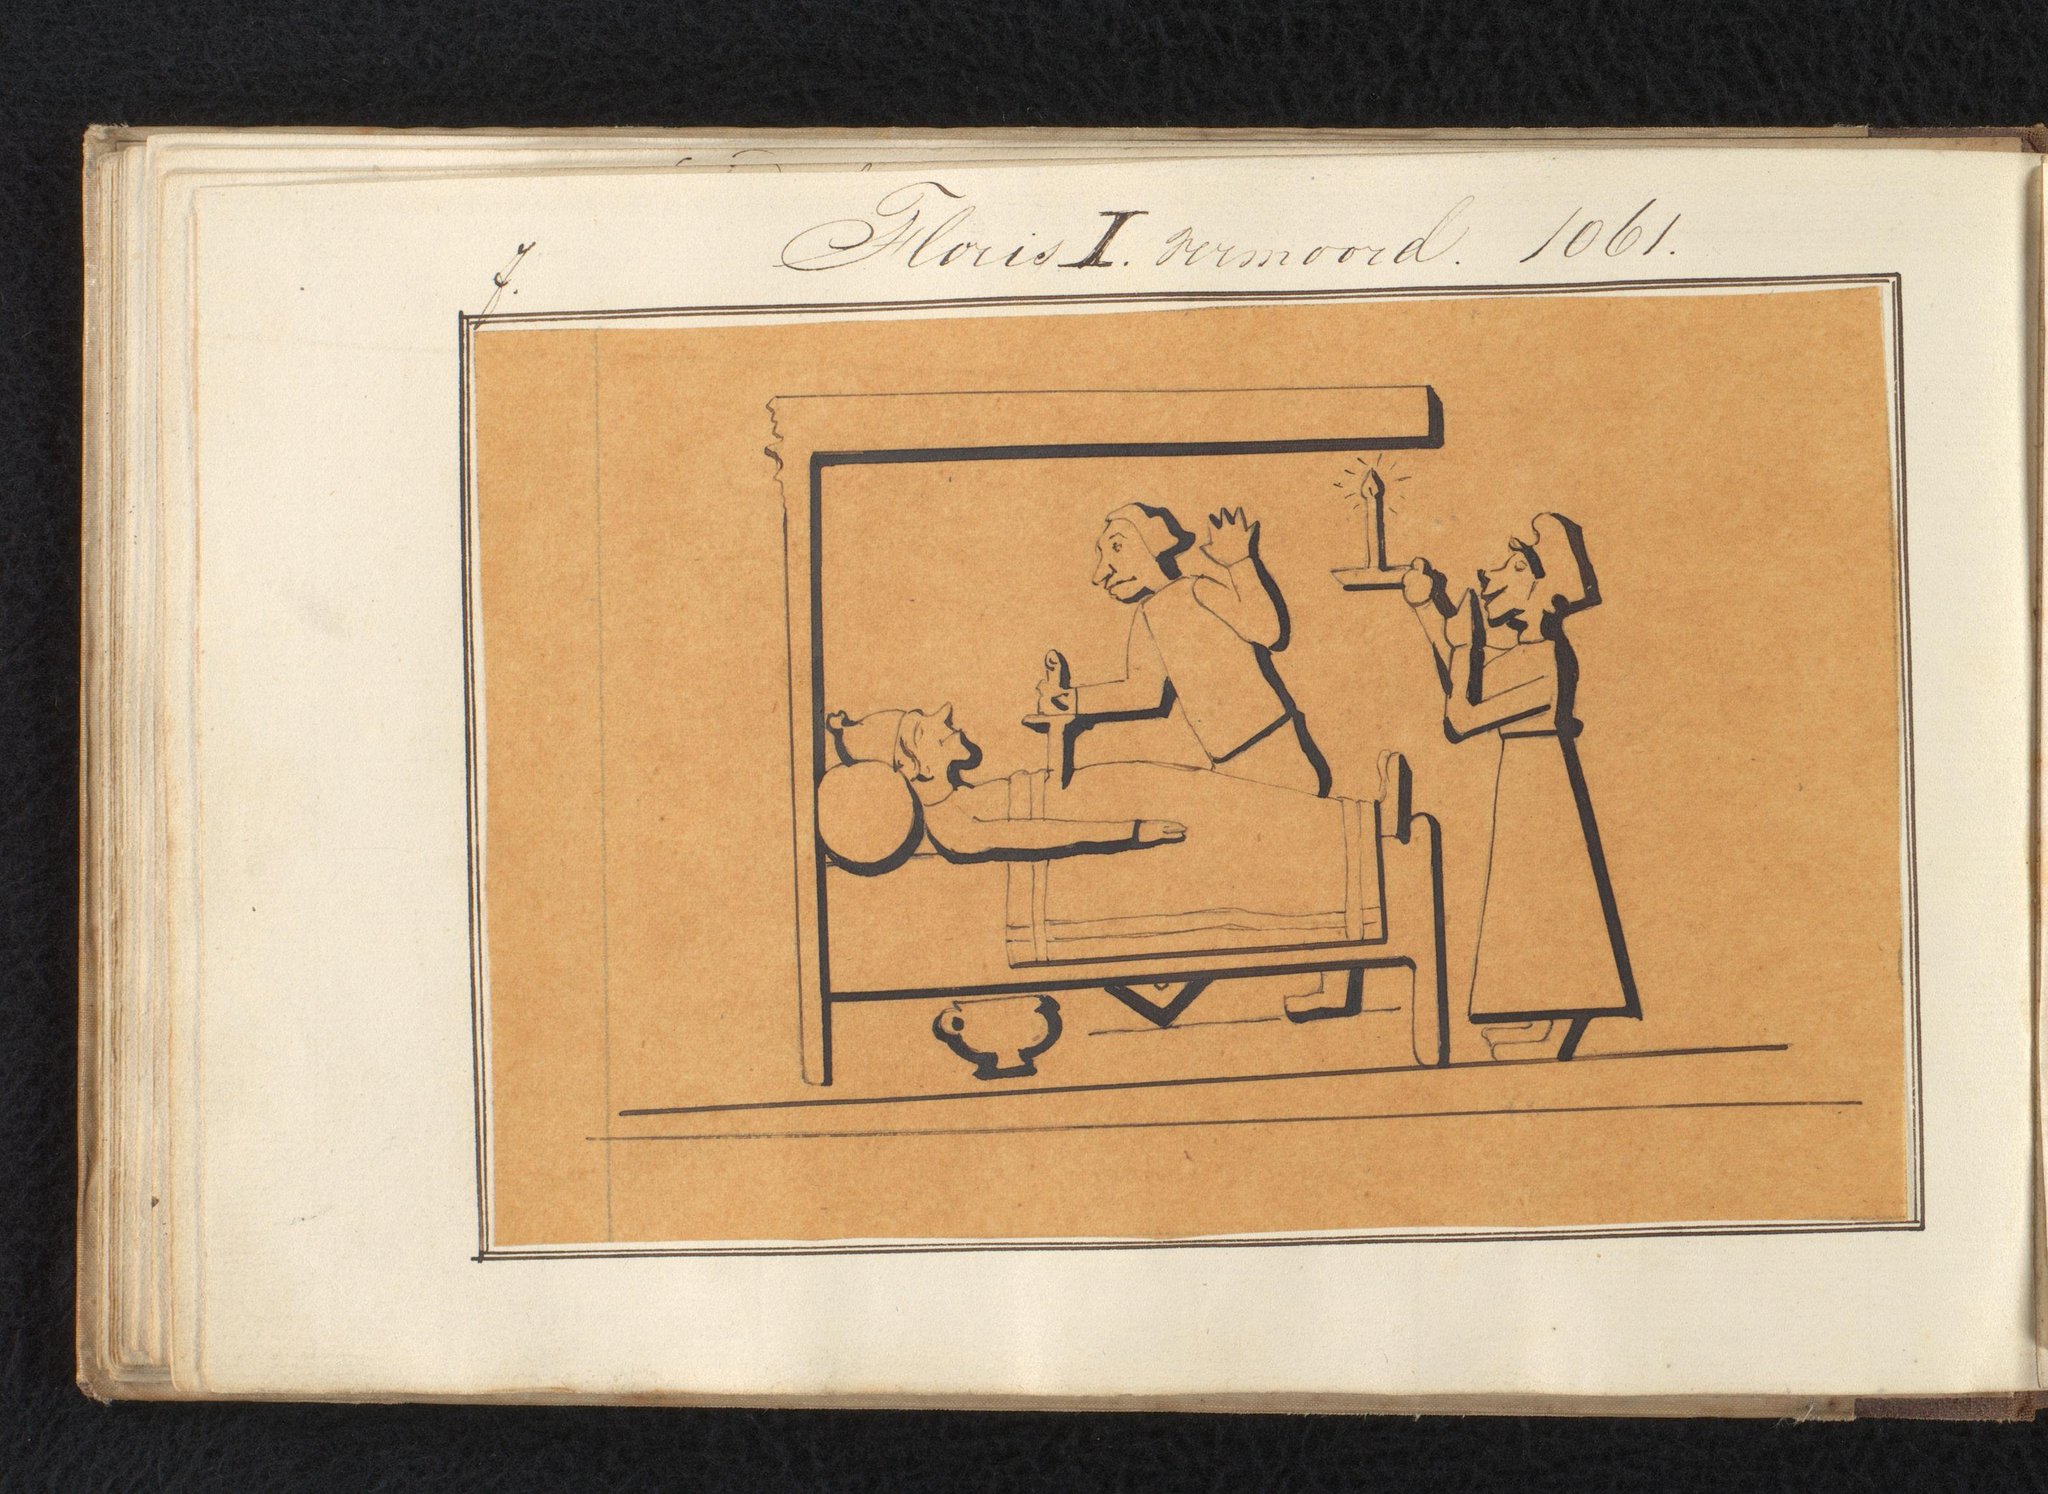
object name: album leaf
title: Floris I vermoord, 1061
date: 1853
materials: ink, pencil, paper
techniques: pen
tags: hacking and thrusting weapons, murder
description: Ontwerp voor: Lennep, Jacob van. Tafereelen uit de geschiedenis des vaderlands, tot nut van groot en klein. Amsterdam: M.H. Binger en Zonen, 1854.